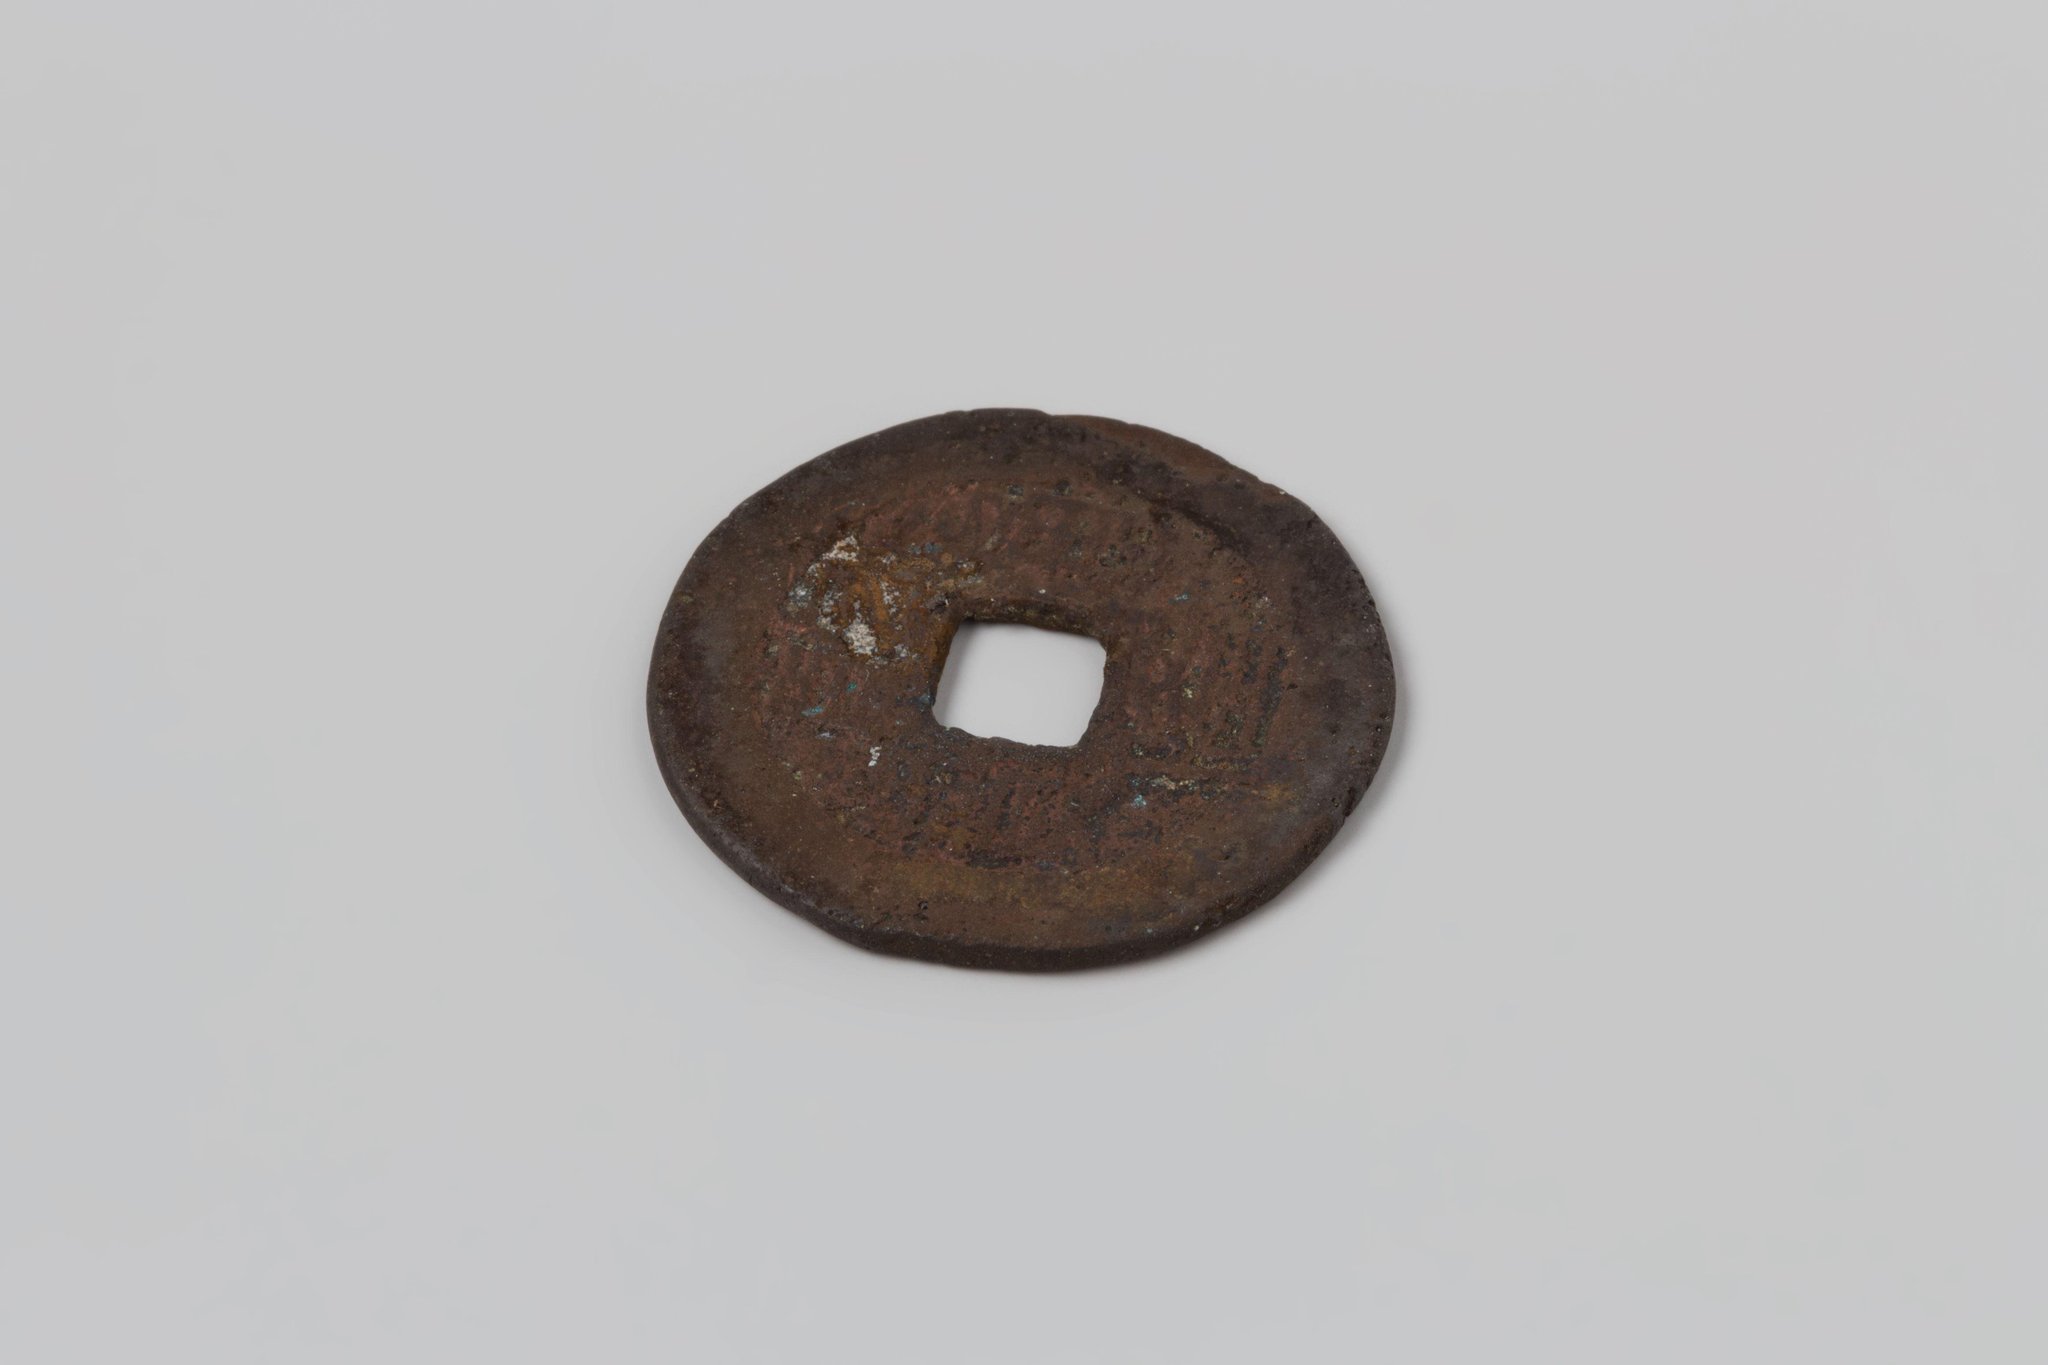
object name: coin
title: Munt uit V.O.C.-schip de 'Witte Leeuw'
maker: Anonymous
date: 1613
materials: copper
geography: china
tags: verenigde oostindische compagnie, sint-helena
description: Munt uit V.O.C.-schip de 'Witte Leeuw'. Chinese roodkoperen munt afkomstig uit een vat.